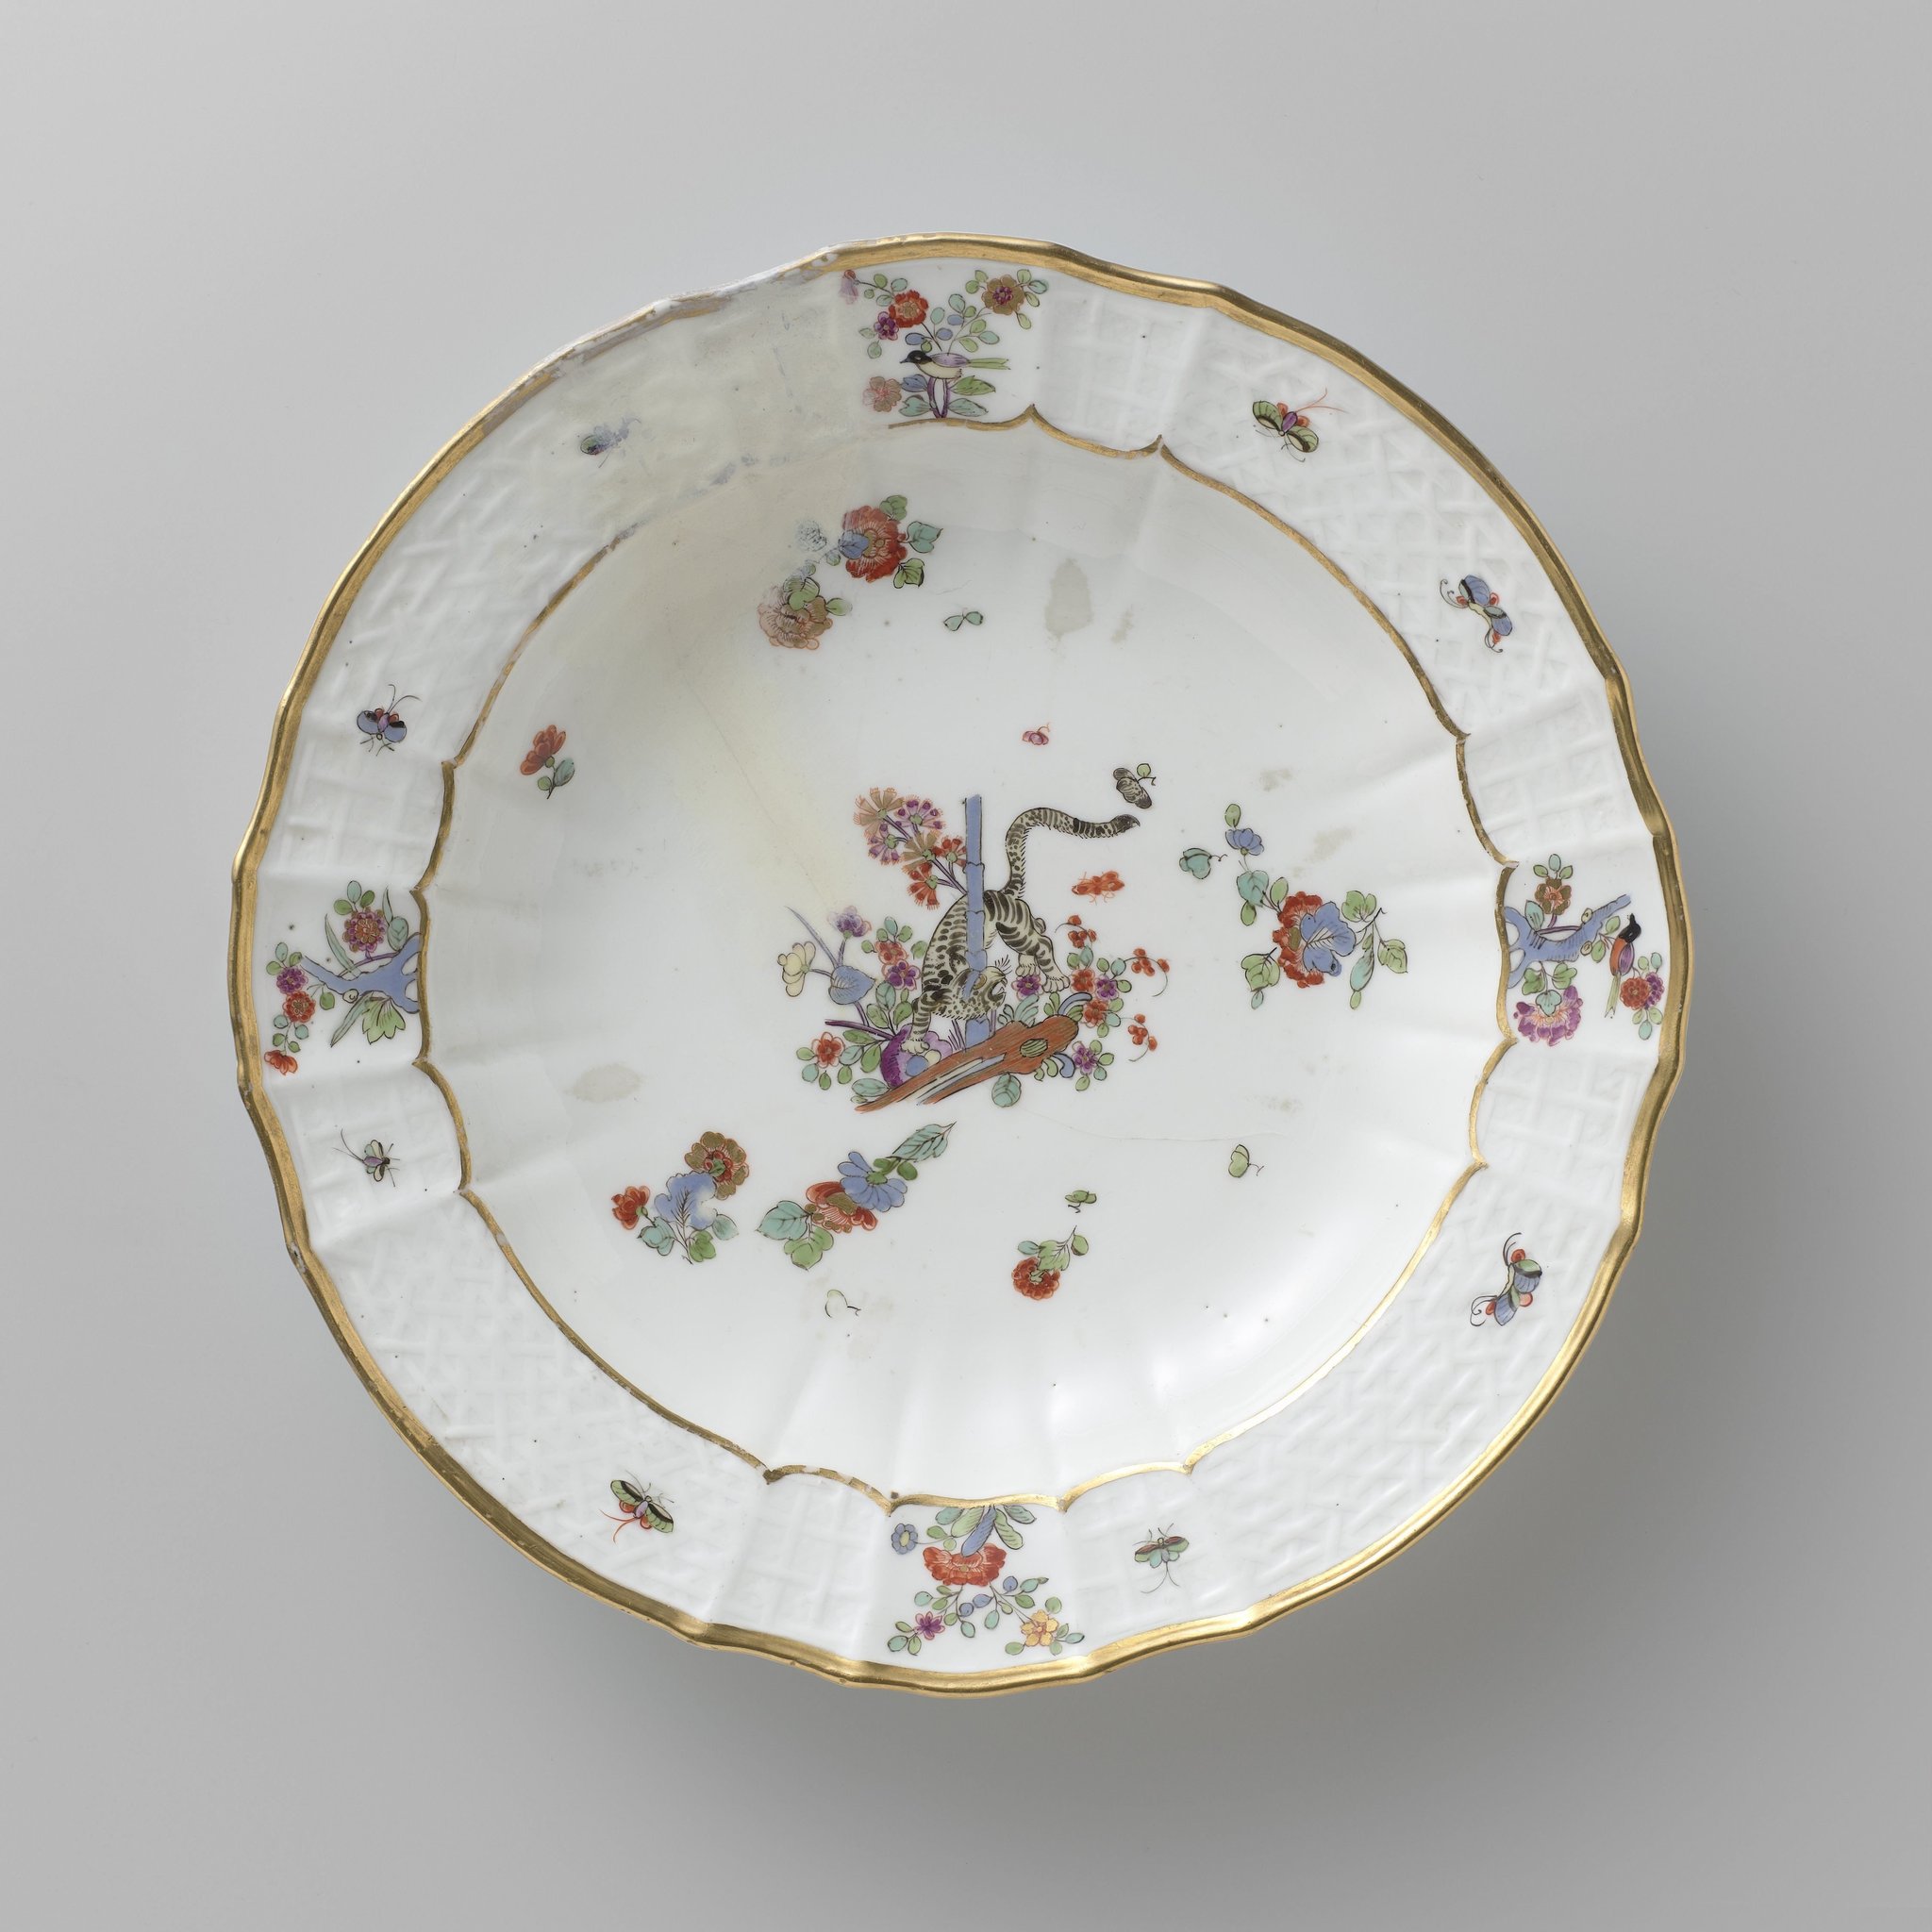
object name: eating drinking utensil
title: Soepbord, veelkleurig beschilderd met een Kakiemon-decor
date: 1740-1745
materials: porcelain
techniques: painted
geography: meissen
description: Soepbord van beschilderd porselein. Het bord heeft een geribde en geschulpte rand. Het bord is beschilderd met een tijger, die zich tussen bloemen om een bamboestengel draait, gestrooide Indianische Blumen, vlinders en takken met vogels. De rand is versierd met het 'Altbrandenstein'-patroon. Het bord is gemerkt.